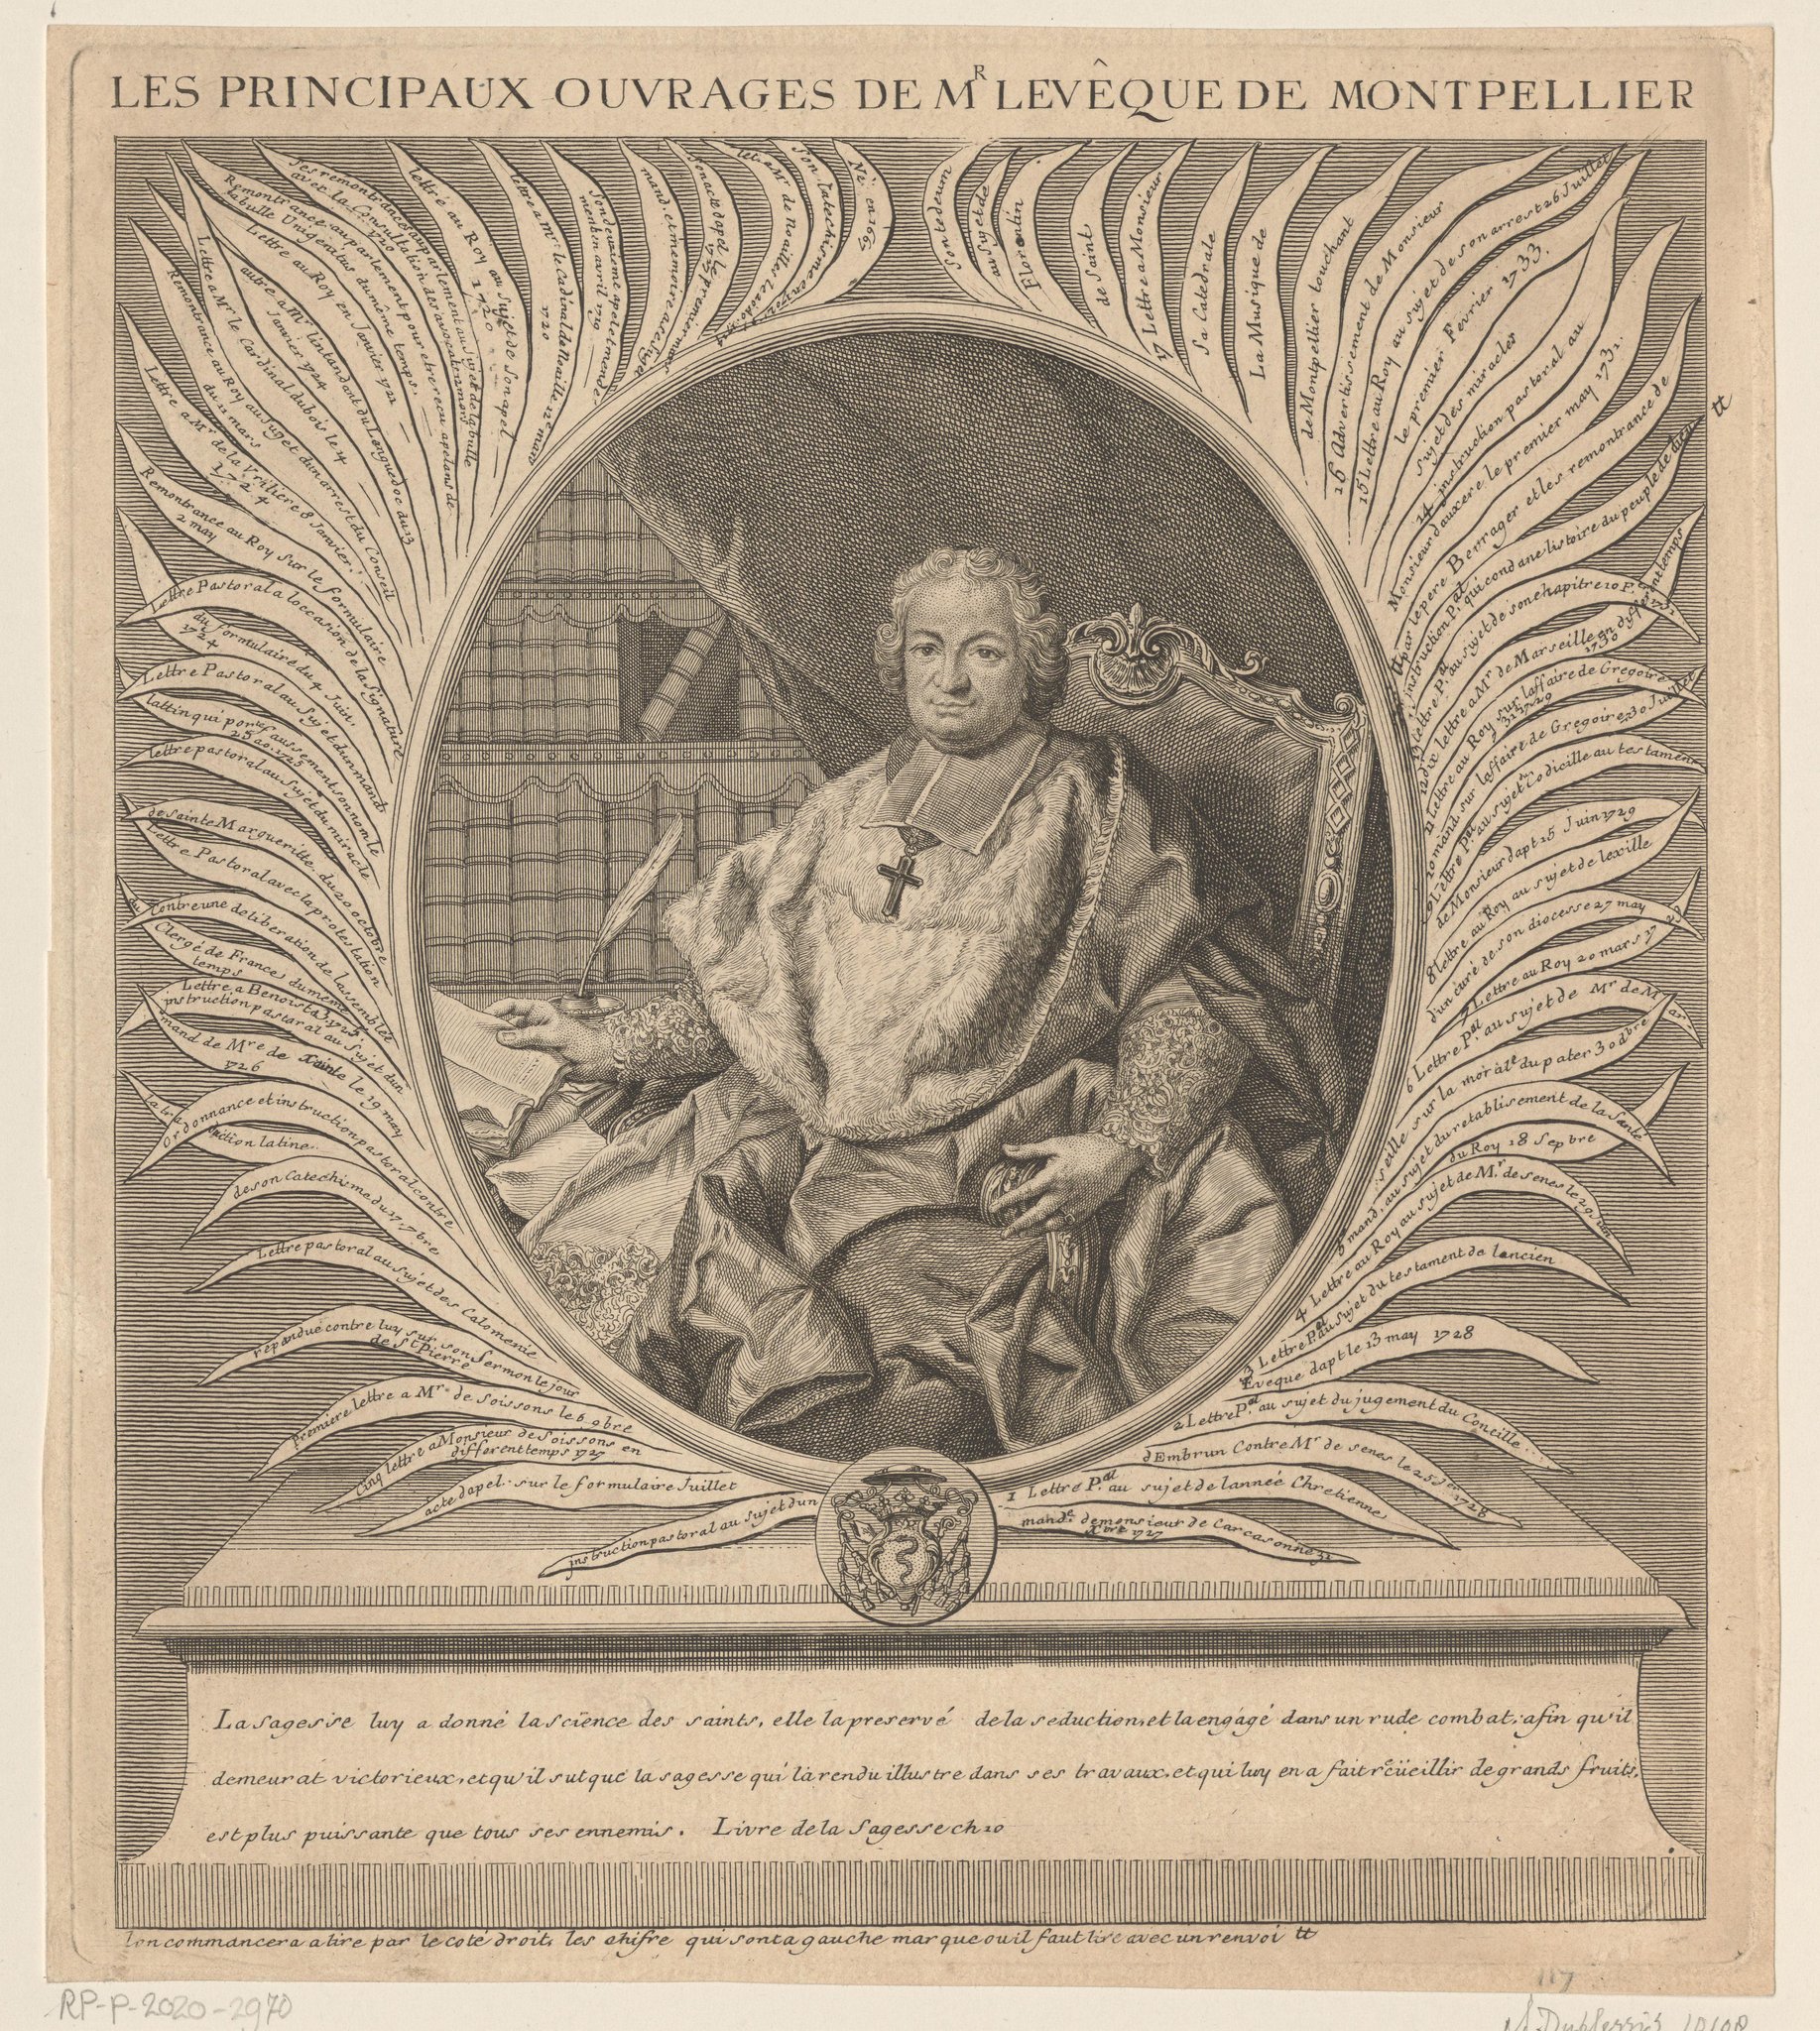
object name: print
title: Portret van Charles-Joachim Colbert de Croissy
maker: Anonymous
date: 1733-1738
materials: paper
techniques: engraving, etching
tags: historical persons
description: In de bladen die het portret omkransen de biografie van de geportretteerde.